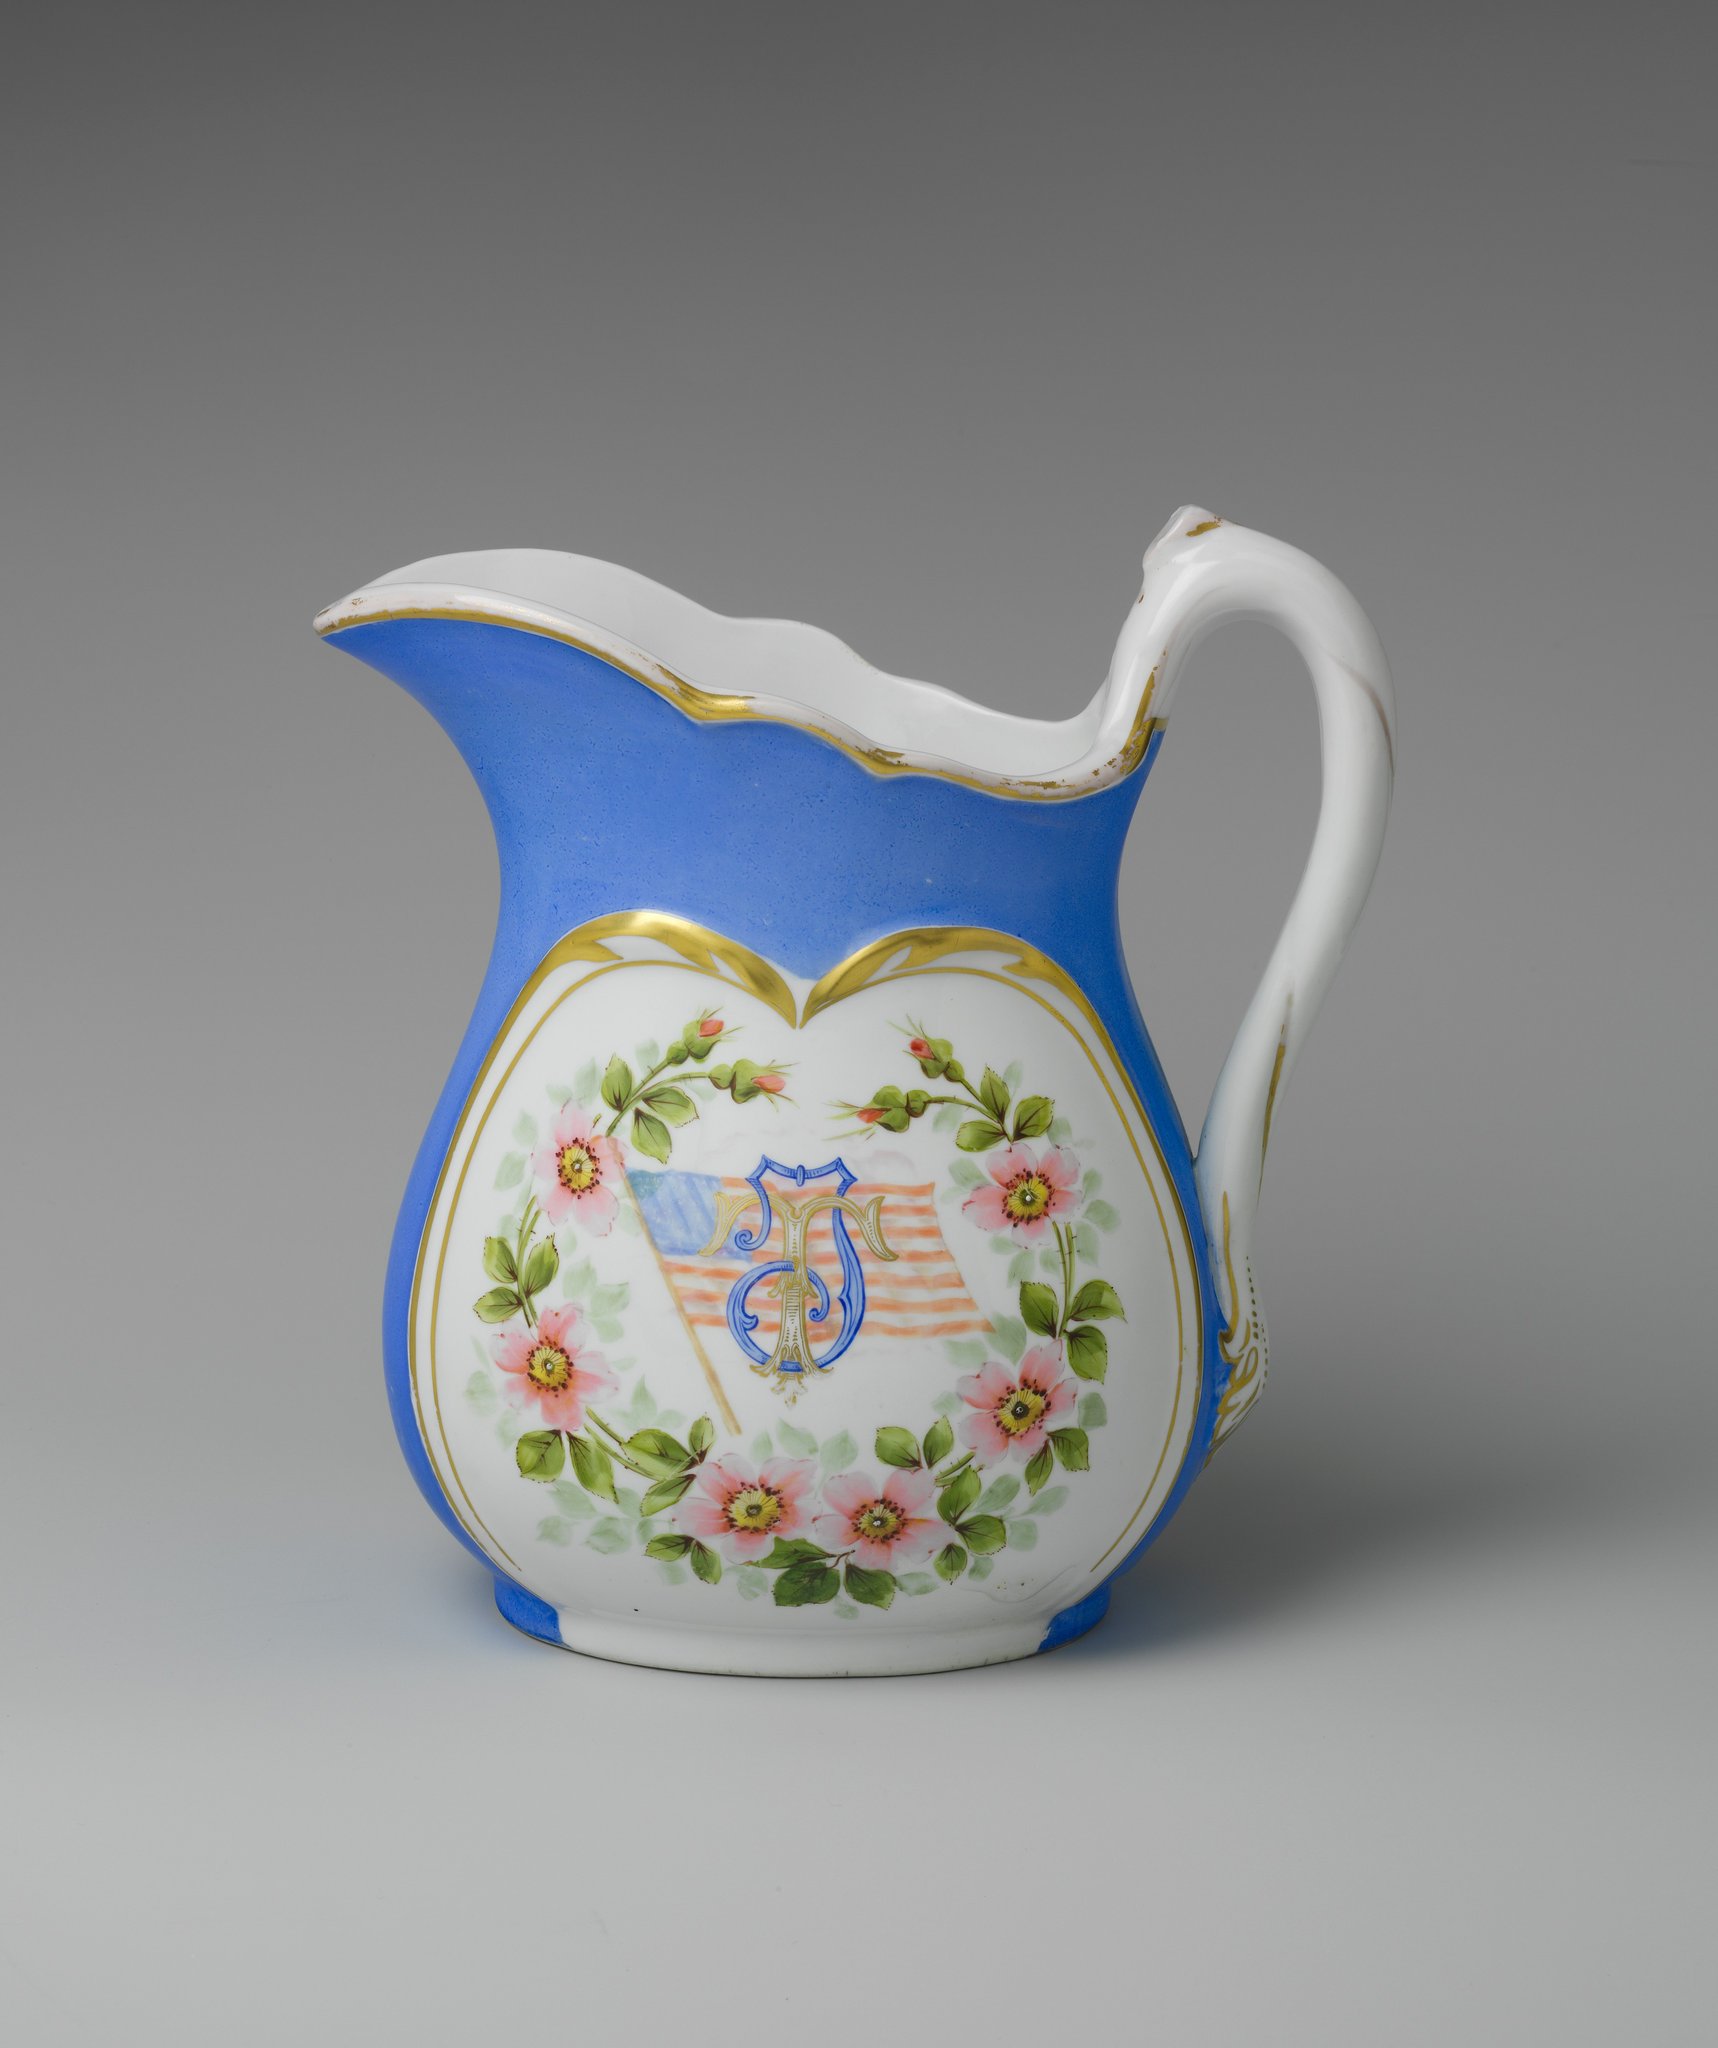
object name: pitcher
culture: american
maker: greenwood pottery company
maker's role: manufacturer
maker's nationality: american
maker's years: 1861-1933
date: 1868-1886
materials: enamel, porcelain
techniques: gilding, overglaze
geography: united states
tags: flowers,flags